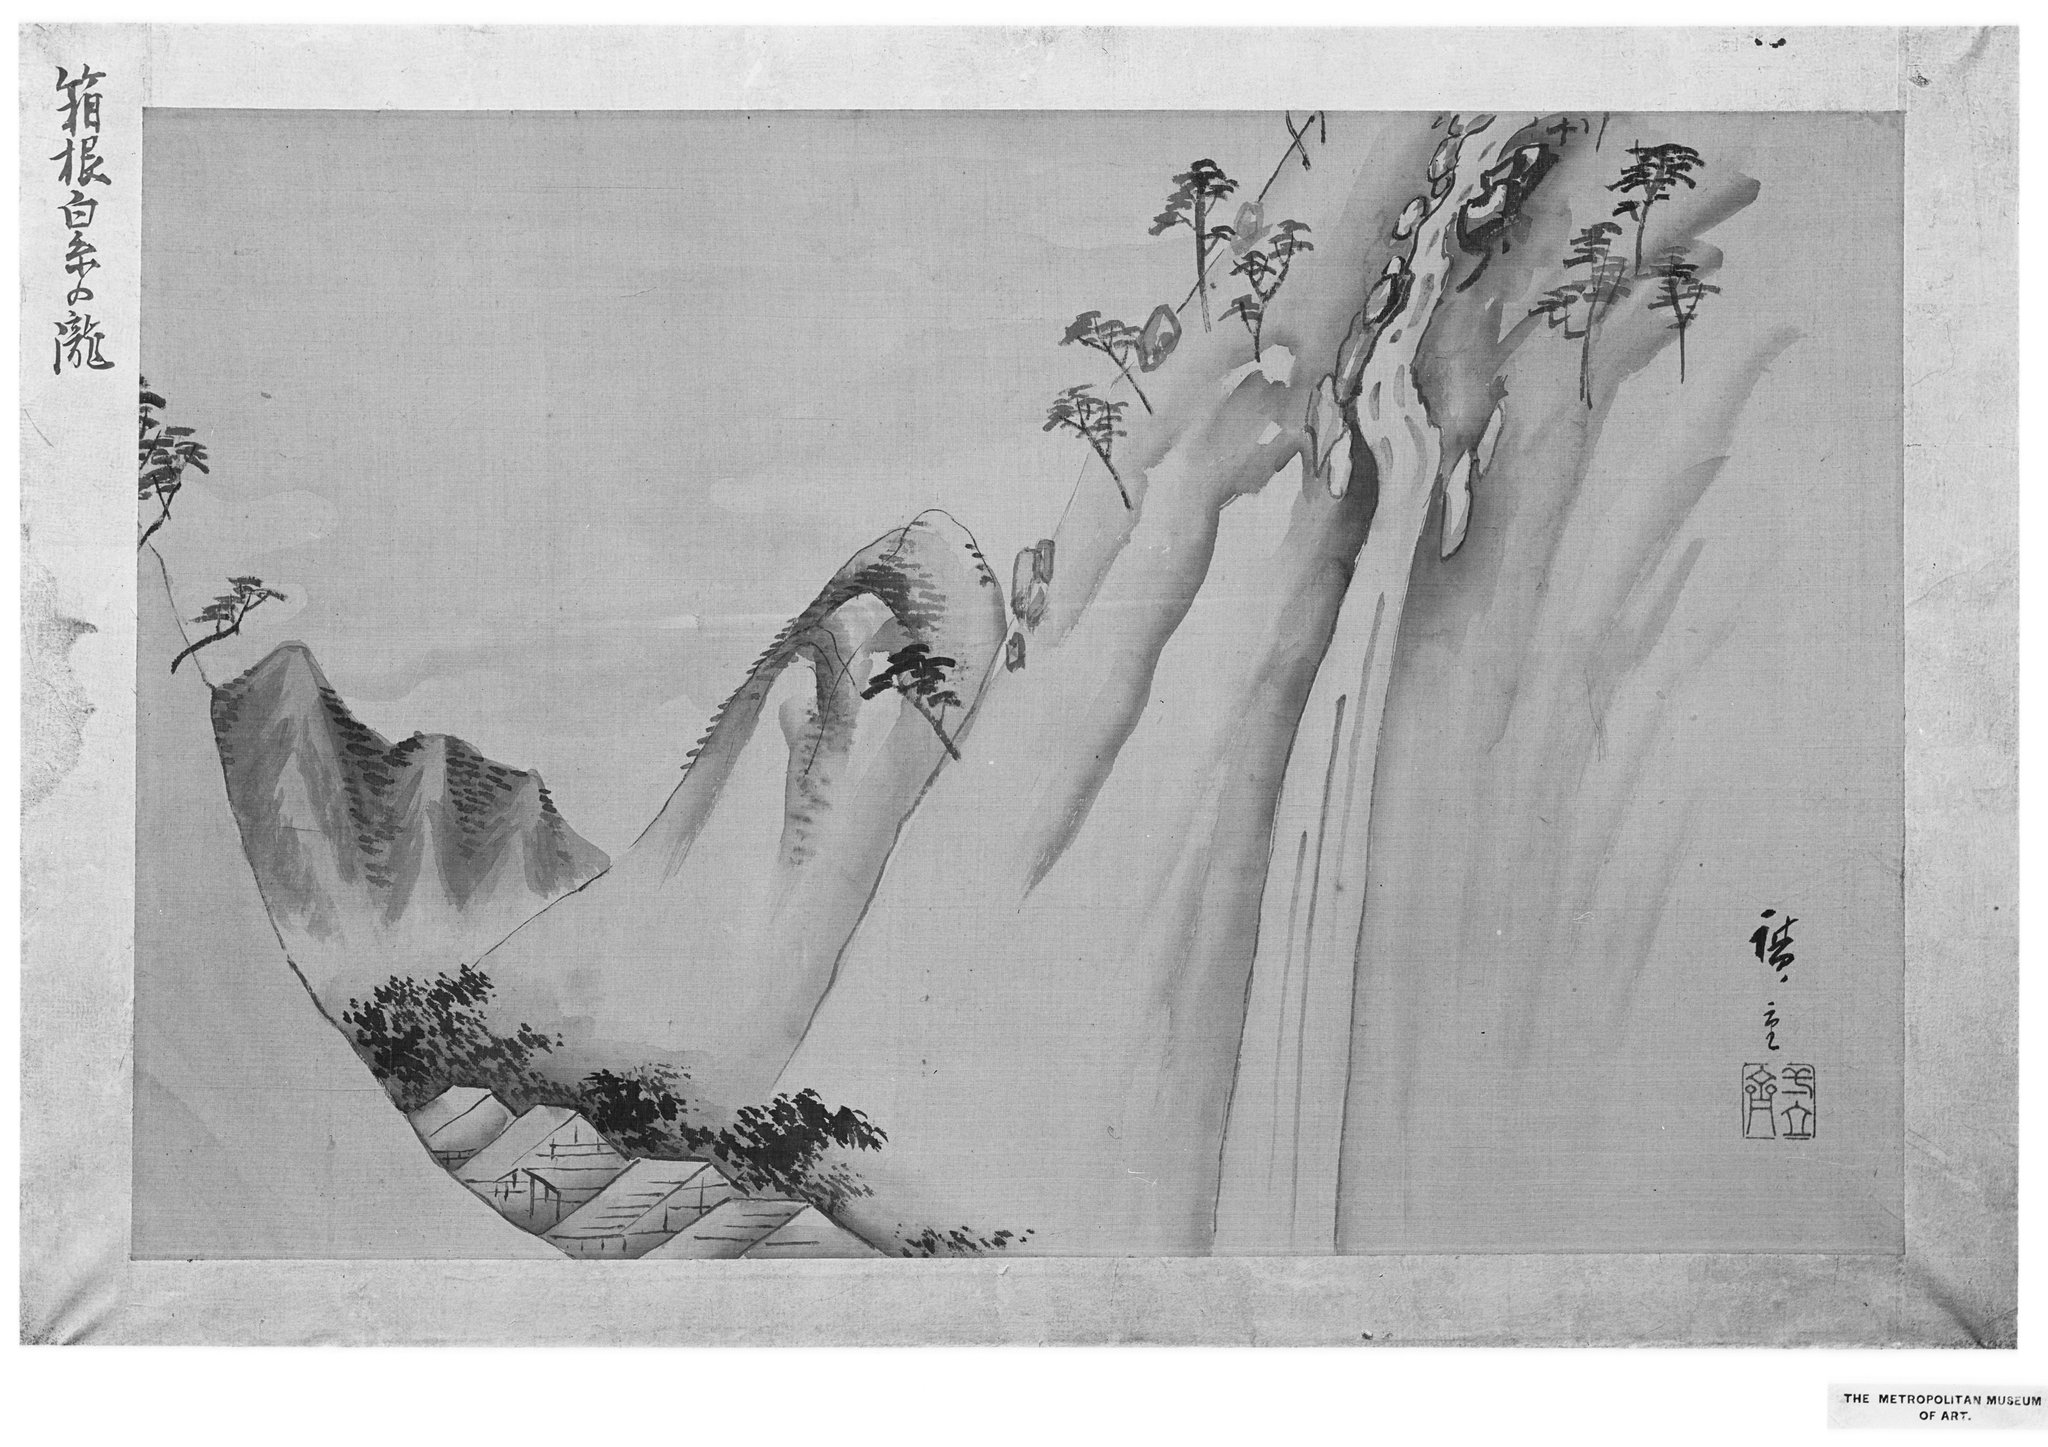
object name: painting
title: Shiraito Waterfall at Hakone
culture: japanese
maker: utagawa hiroshige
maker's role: artist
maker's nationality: japanese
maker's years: 1797-1858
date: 1801-1900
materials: ink, silk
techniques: painting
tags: waterfalls